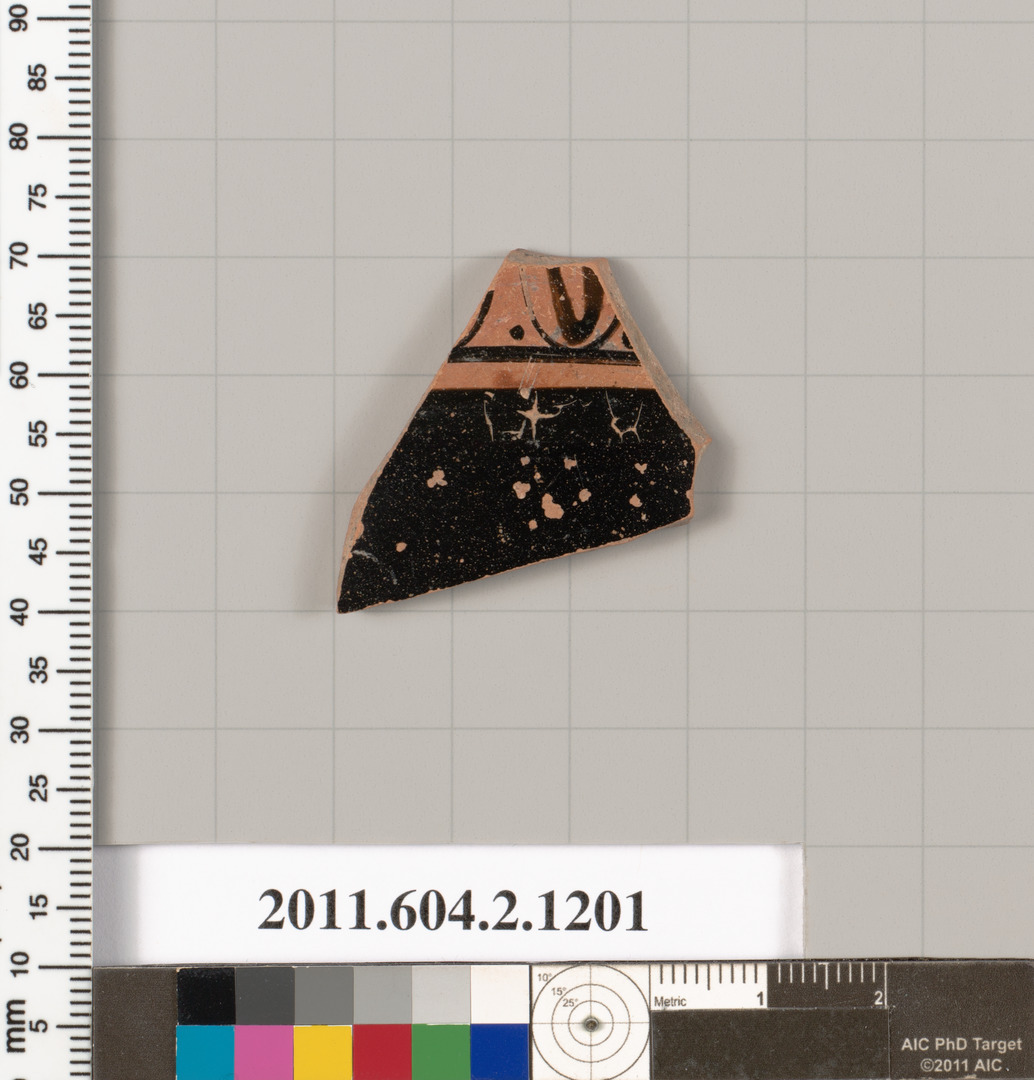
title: Terracotta fragment from an open shape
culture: greek, attic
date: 450-401 BCE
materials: terracotta